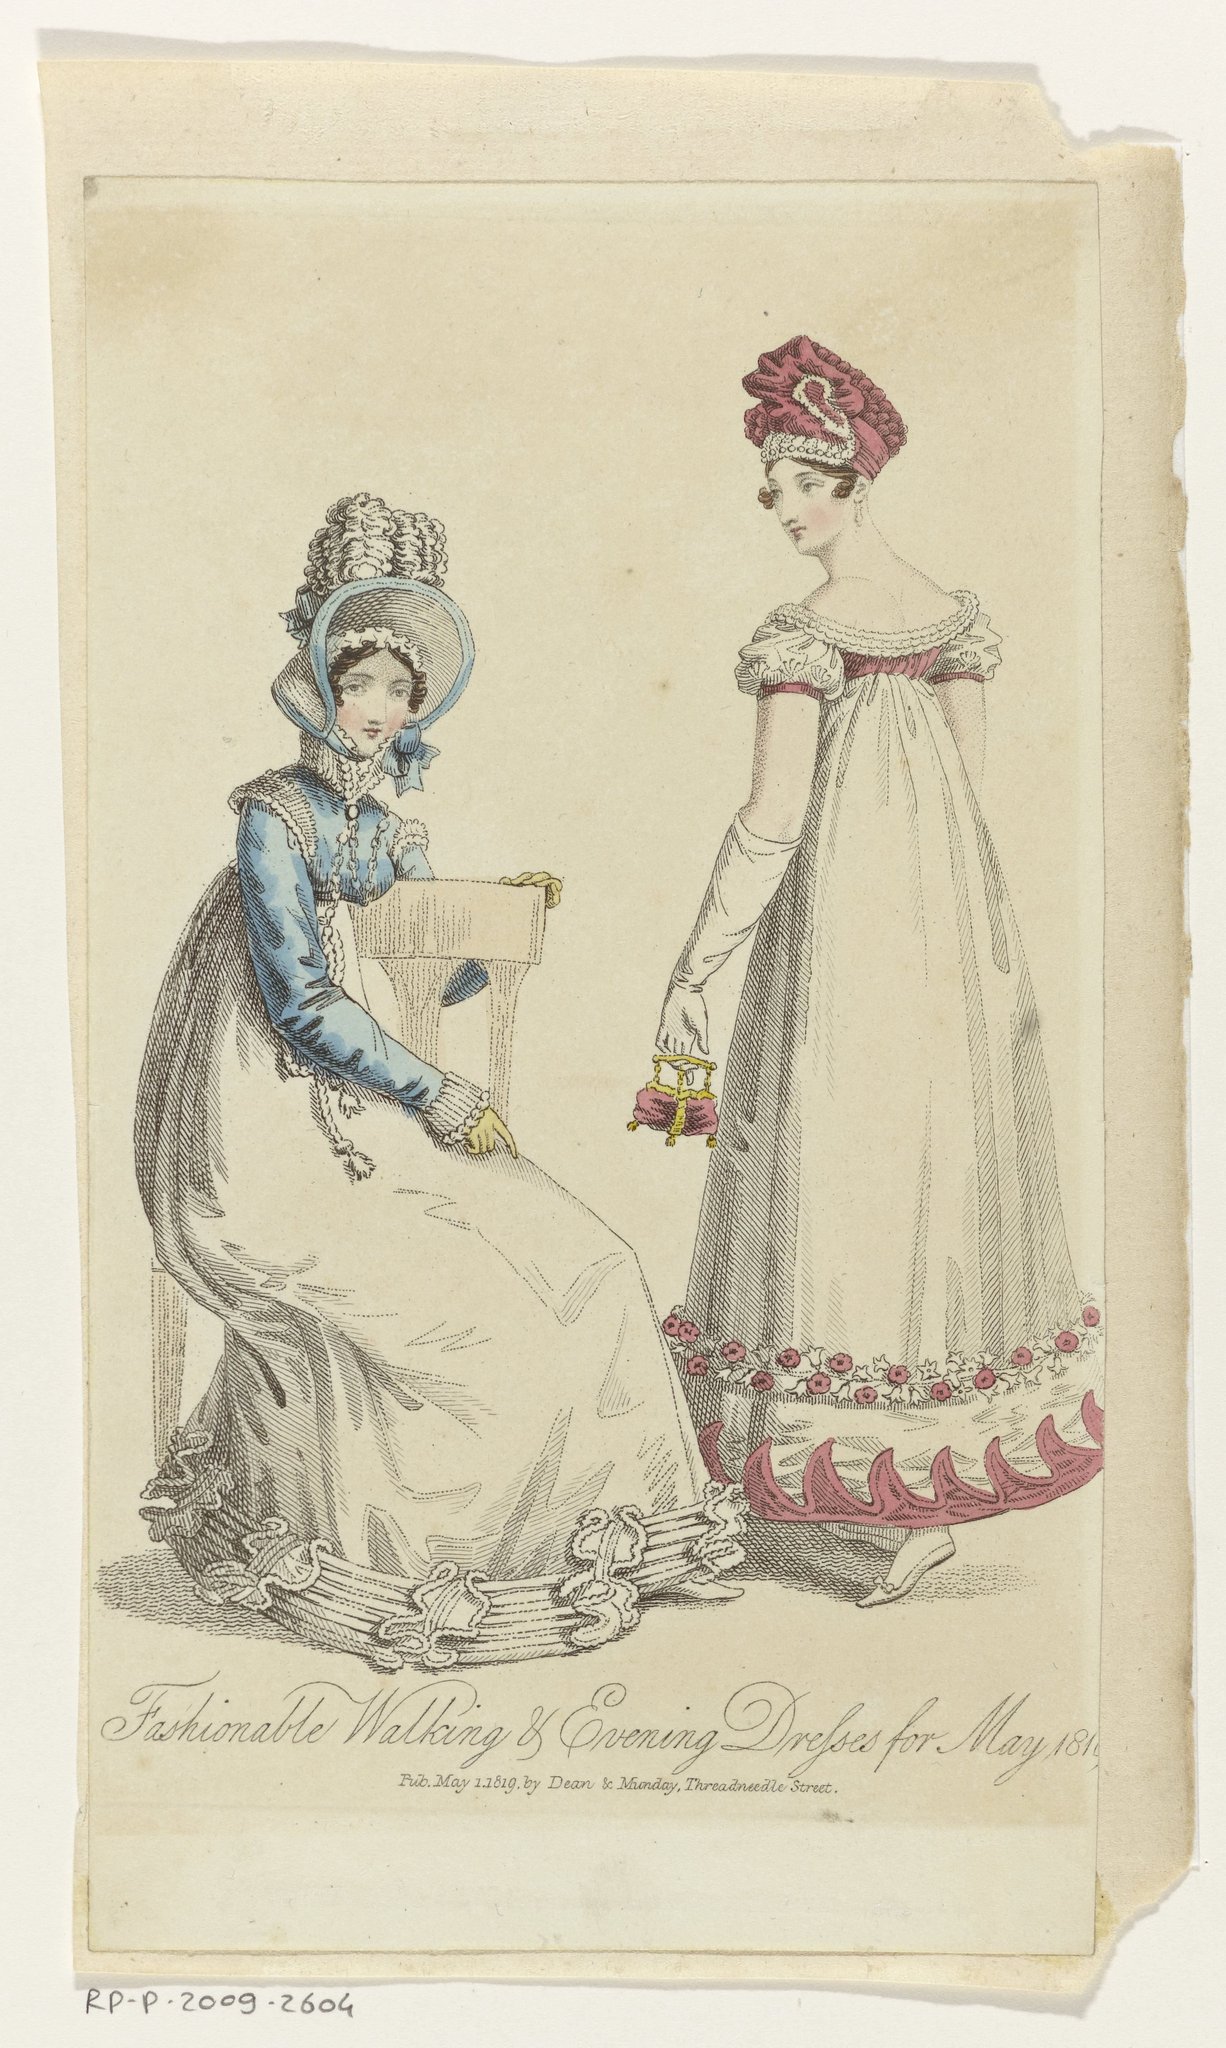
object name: fashion print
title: Fashionable Walking & Evening Dresses for May 1819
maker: Anonymous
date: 1819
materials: paper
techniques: etching, hand coloring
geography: london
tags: dress, gown: evening dress (+ women's clothes), head-gear: turban (+ women's clothes), gloves, mittens (long gloves) (+ women's clothes), dress, gown: walking dress (+ women's clothes), bag (handbag) (+ women's clothes), clothing for the upper part of the body (spencer) (+ women's clothes), fashion plates, shoes, sandals (+ women's clothes)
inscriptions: address: ‘Pub. May 1. 1819, by Dean & Munday, Threadneedle Street.’, caption: ‘Fashionable Walking & Evening Dresses for May 1819’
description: Modieuze wandeljapon en avondjapon voor het voorjaar van 1819. Links: wandeljapon met spencer. Accessoires: luifelhoed met veren, handschoenen. Rechts: avondjapon met korte pofmouwen. Accessoires: tulband(?), oorbel in het linkeroor, lange handschoen, tasje, platte schoenen met strikken.